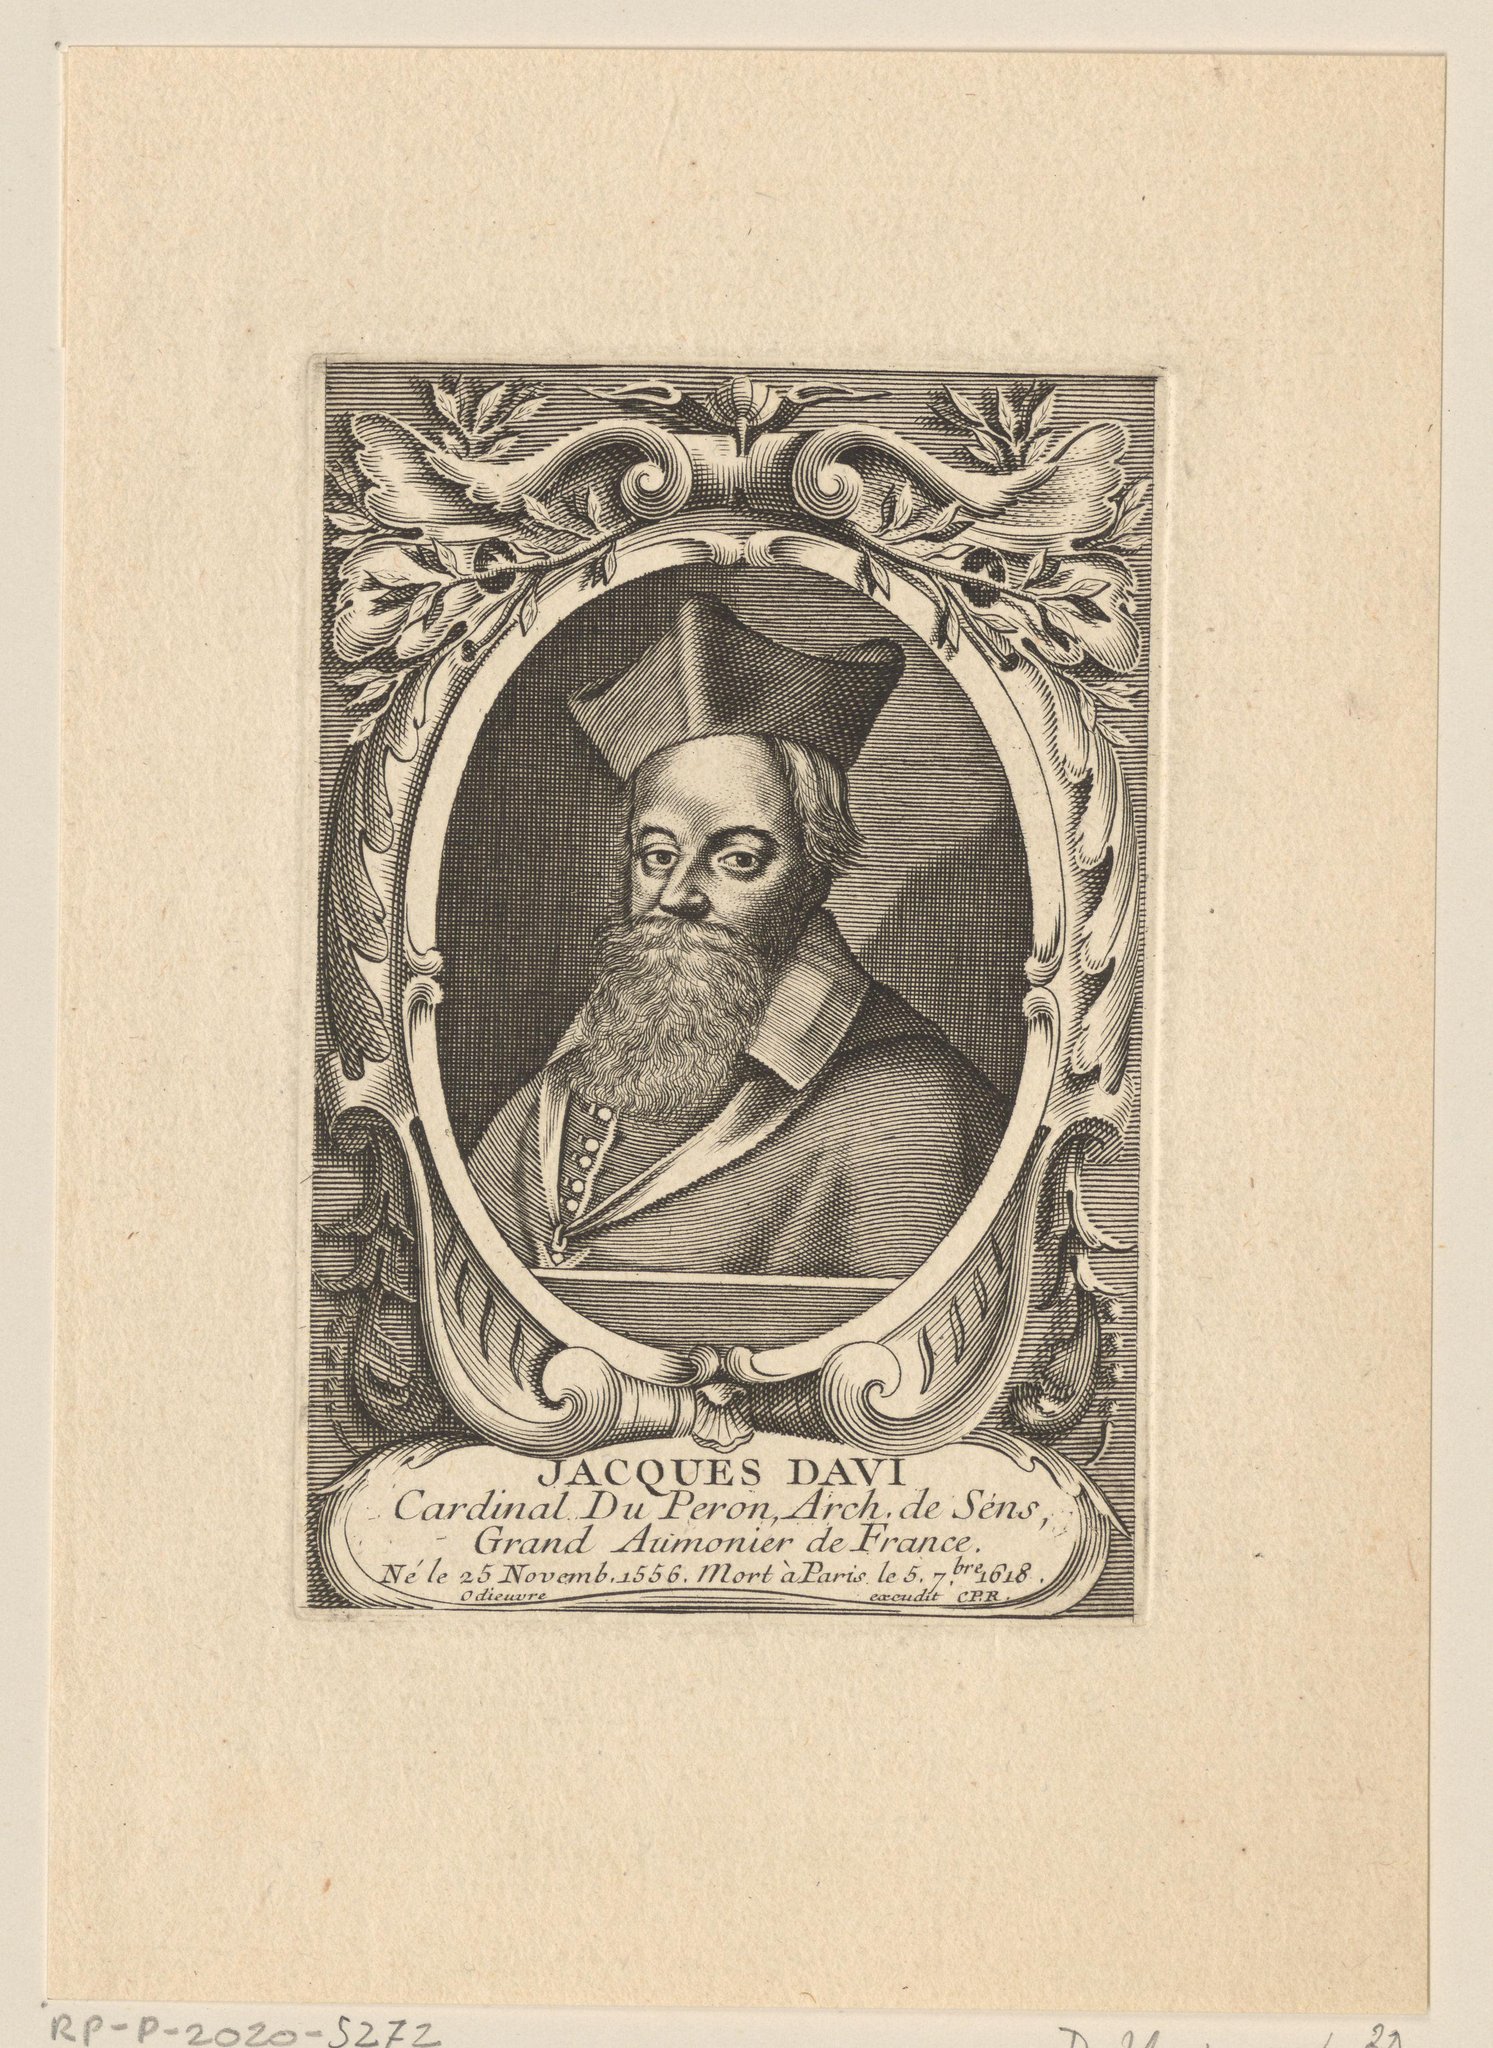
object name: print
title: Portret van Jacques Davy Duperron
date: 1697-1756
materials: paper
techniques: engraving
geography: paris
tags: cardinal, historical persons